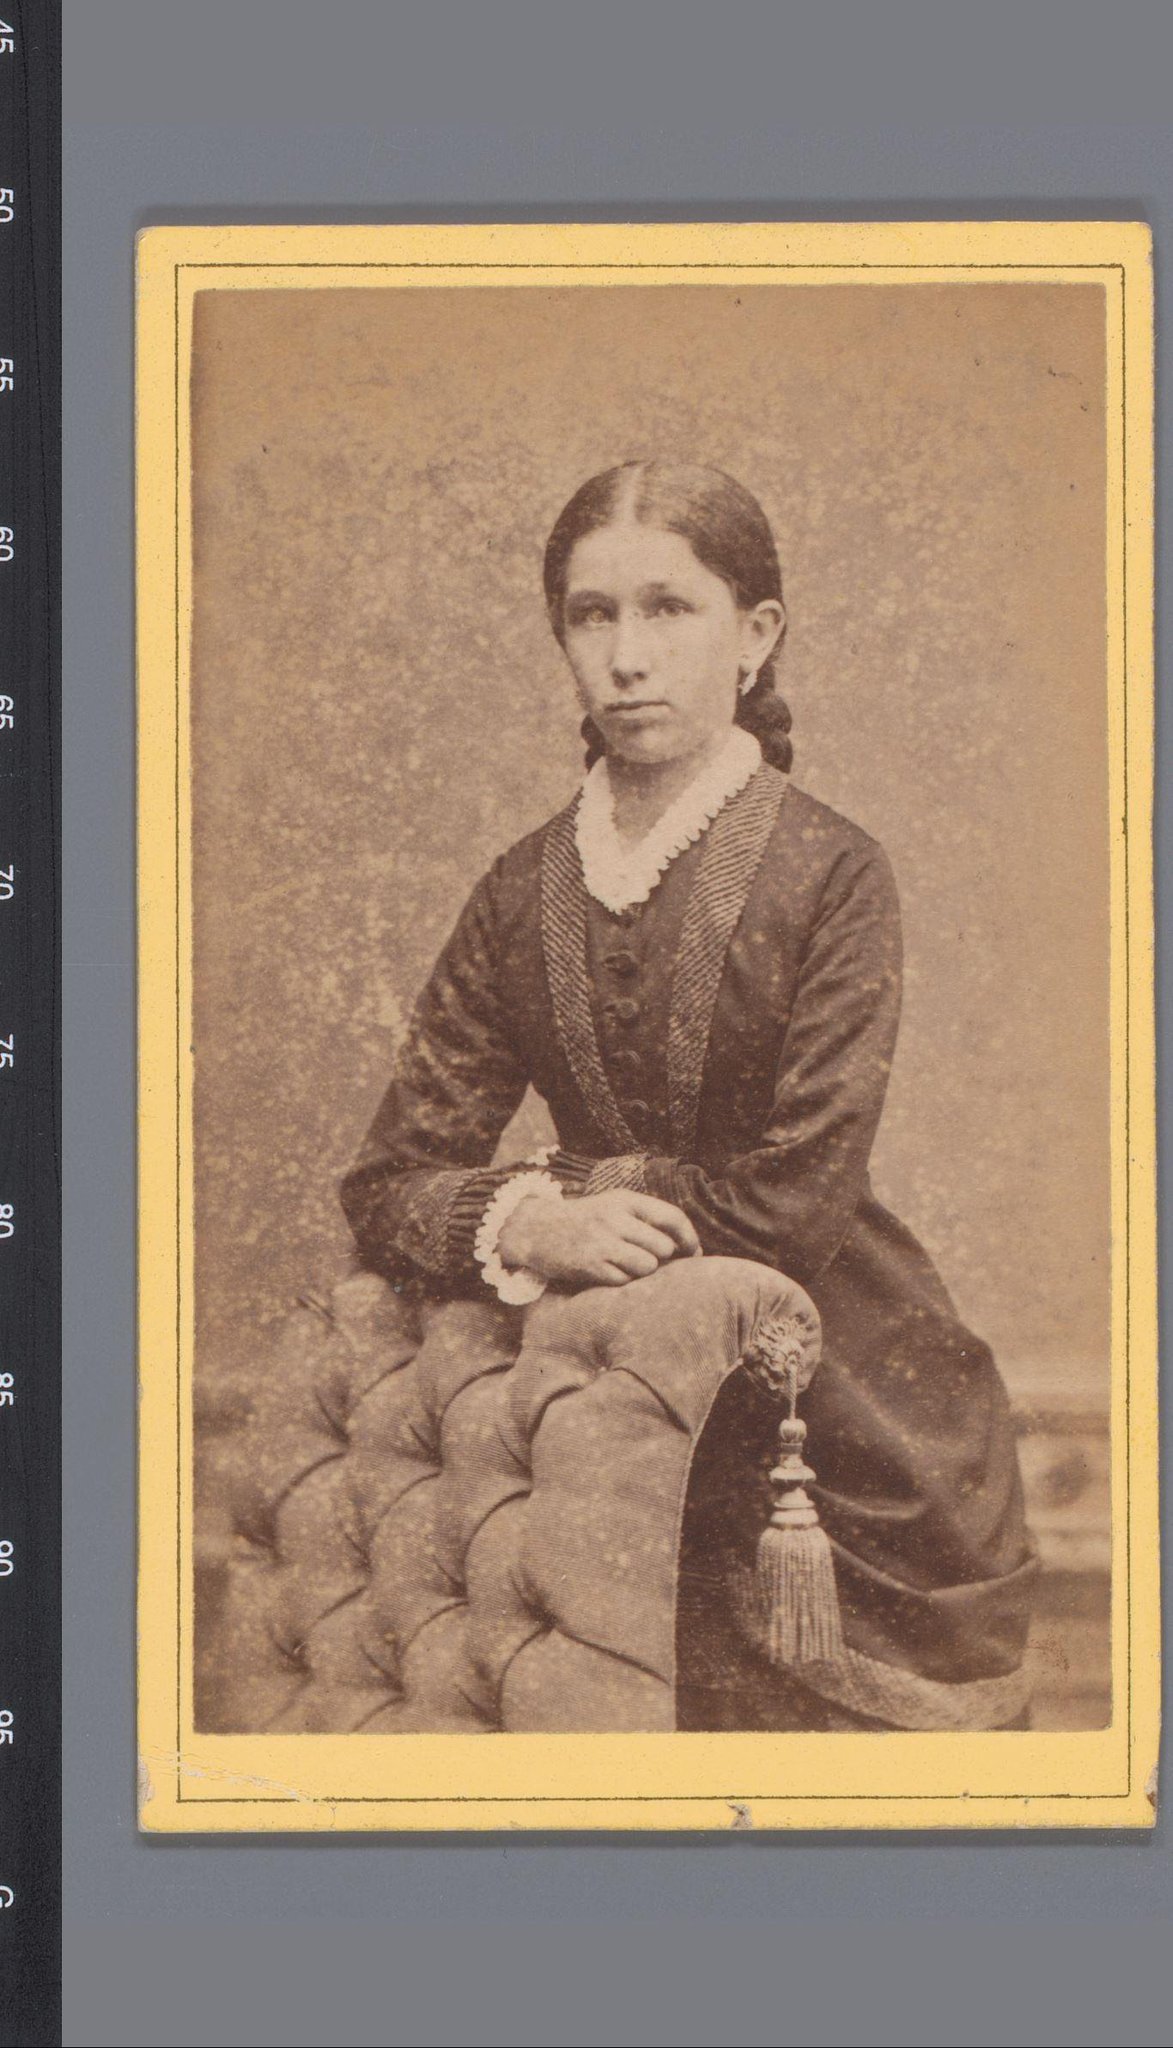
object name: photograph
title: Portret van een onbekende vrouw, staande achter een fauteuil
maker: friedrich julius von kolkow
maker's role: fotograaf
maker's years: 1839-1914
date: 1884-1896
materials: cardboard, paper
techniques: albumen print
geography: groningen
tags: historical persons - bb - woman, chair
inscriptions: inscription: ‘PHILADELPHIA/ 1876./ 1879./ GOUDEN MEDALJE VOOR KUNST EN WETENSCHAP/ VAN Z.M. den Koning van Württemberg/ te dragen aan het lint der Frederiksorde/ MEDALJE VOOR KUNST EN WETENSCHAP/ van/ Z.K.H. den Groothertog van Oldenburg 1877./ MEDALJE VAN VERDIENSTE WEENEN 1873./ Zilveren Voigtländer Prijsvraag Medalje1875./ EN ACHT ZILVEREN PRIJS MEDALJEN./ FR. JUL. VON KOLKOW/ Hof-PHotograaf/ van Z.M. den Koning/ en wijlen Z.K.H. Prins Hendrik der Nederlanden./ GRONINGEN.’